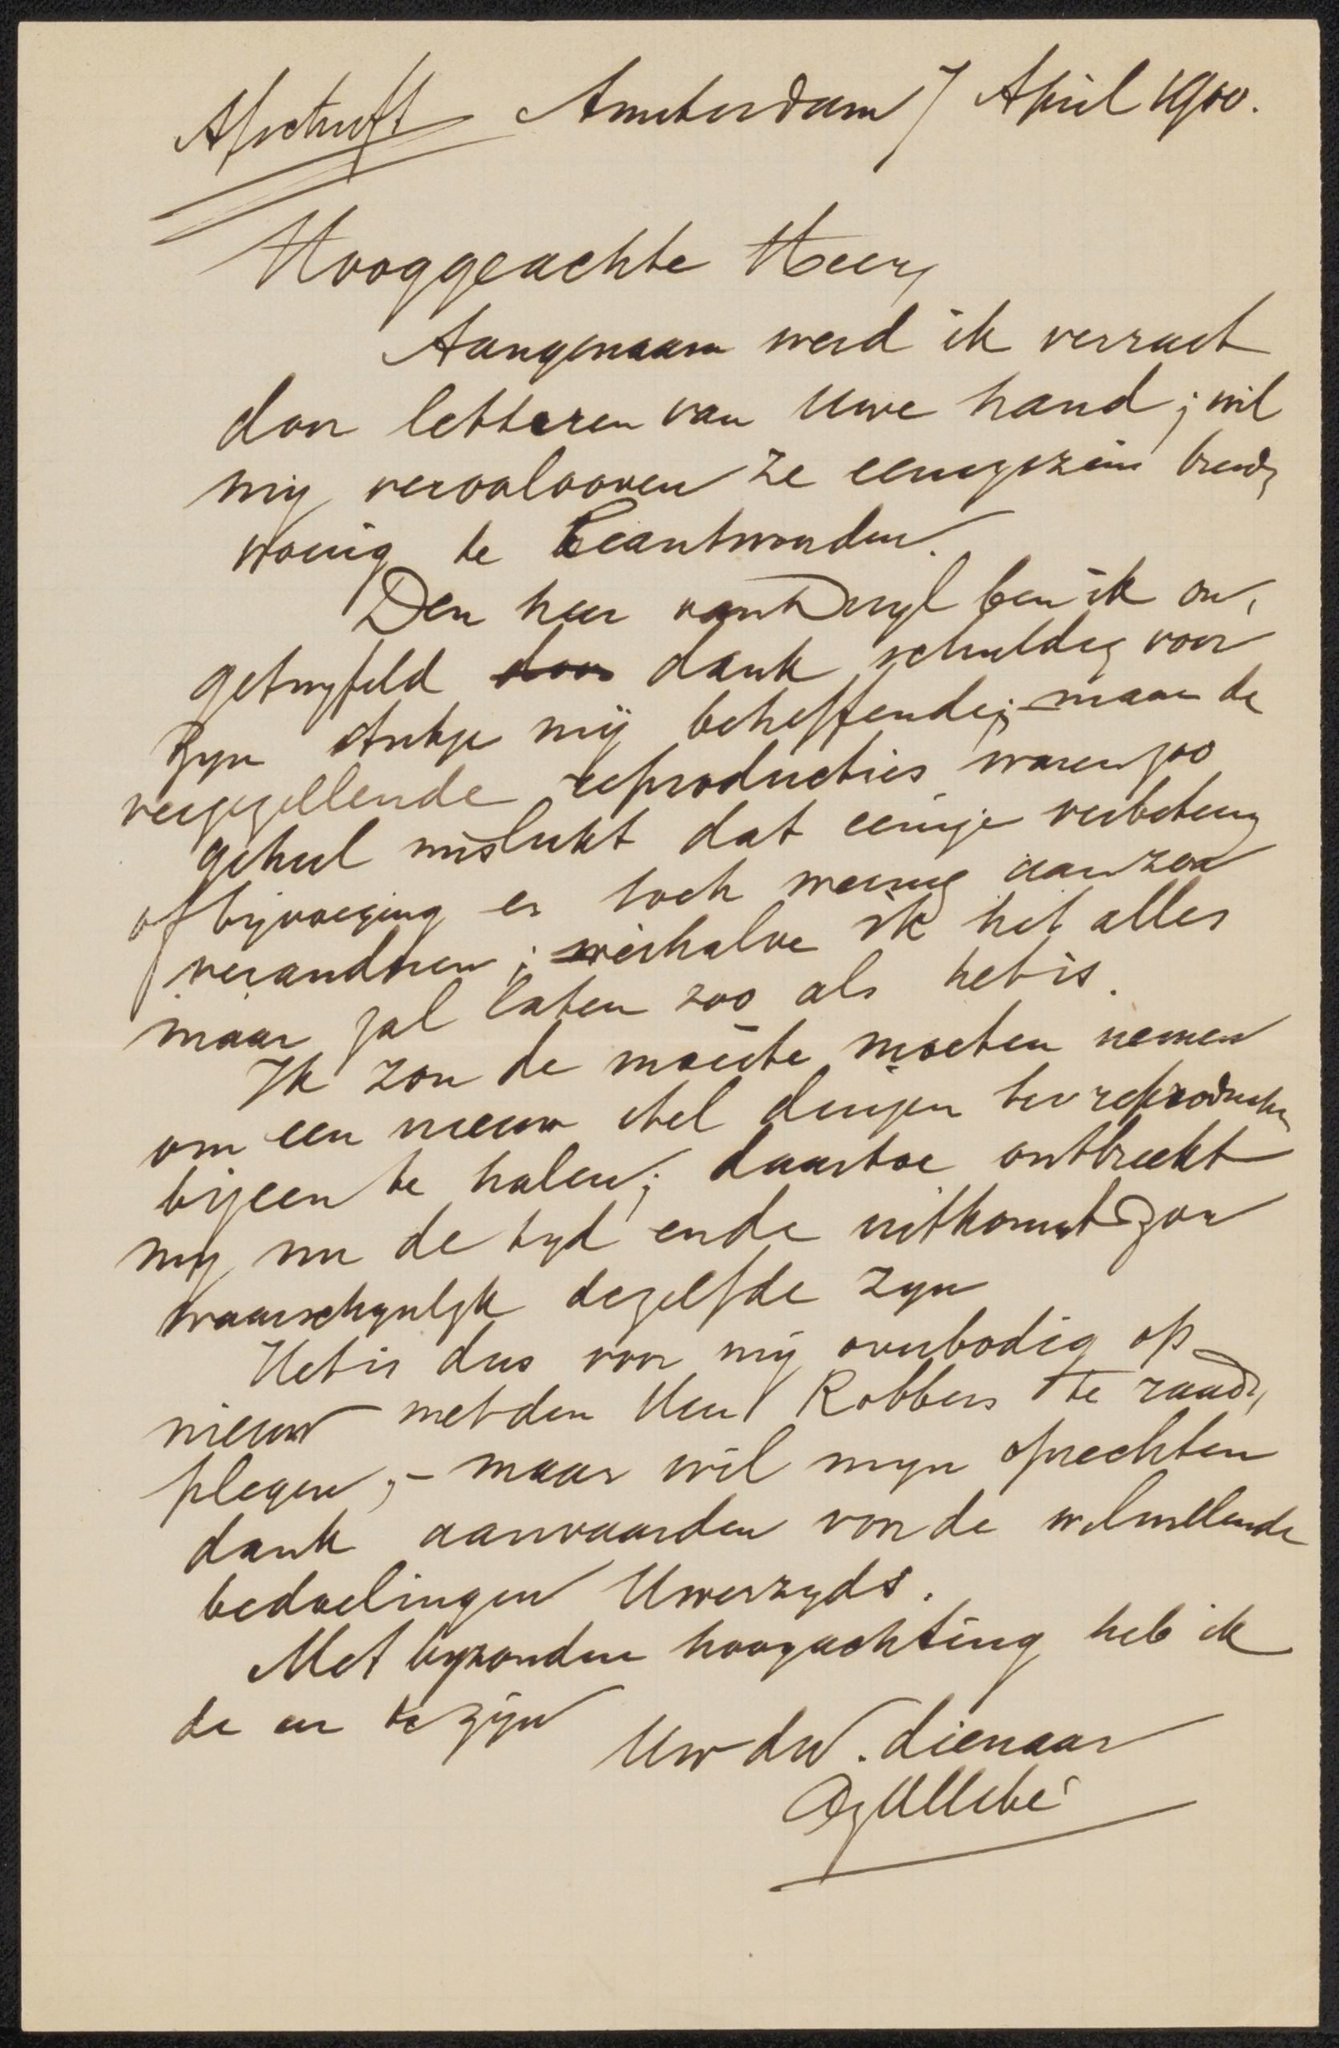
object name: letter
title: Brief aan anoniem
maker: august allebé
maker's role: draughtsman, print maker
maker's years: 1838-1927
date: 1900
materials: ink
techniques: pen, writing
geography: amsterdam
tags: brielle, anton gilles cornelis van duyl, rotterdam, herman robbers, printed matter